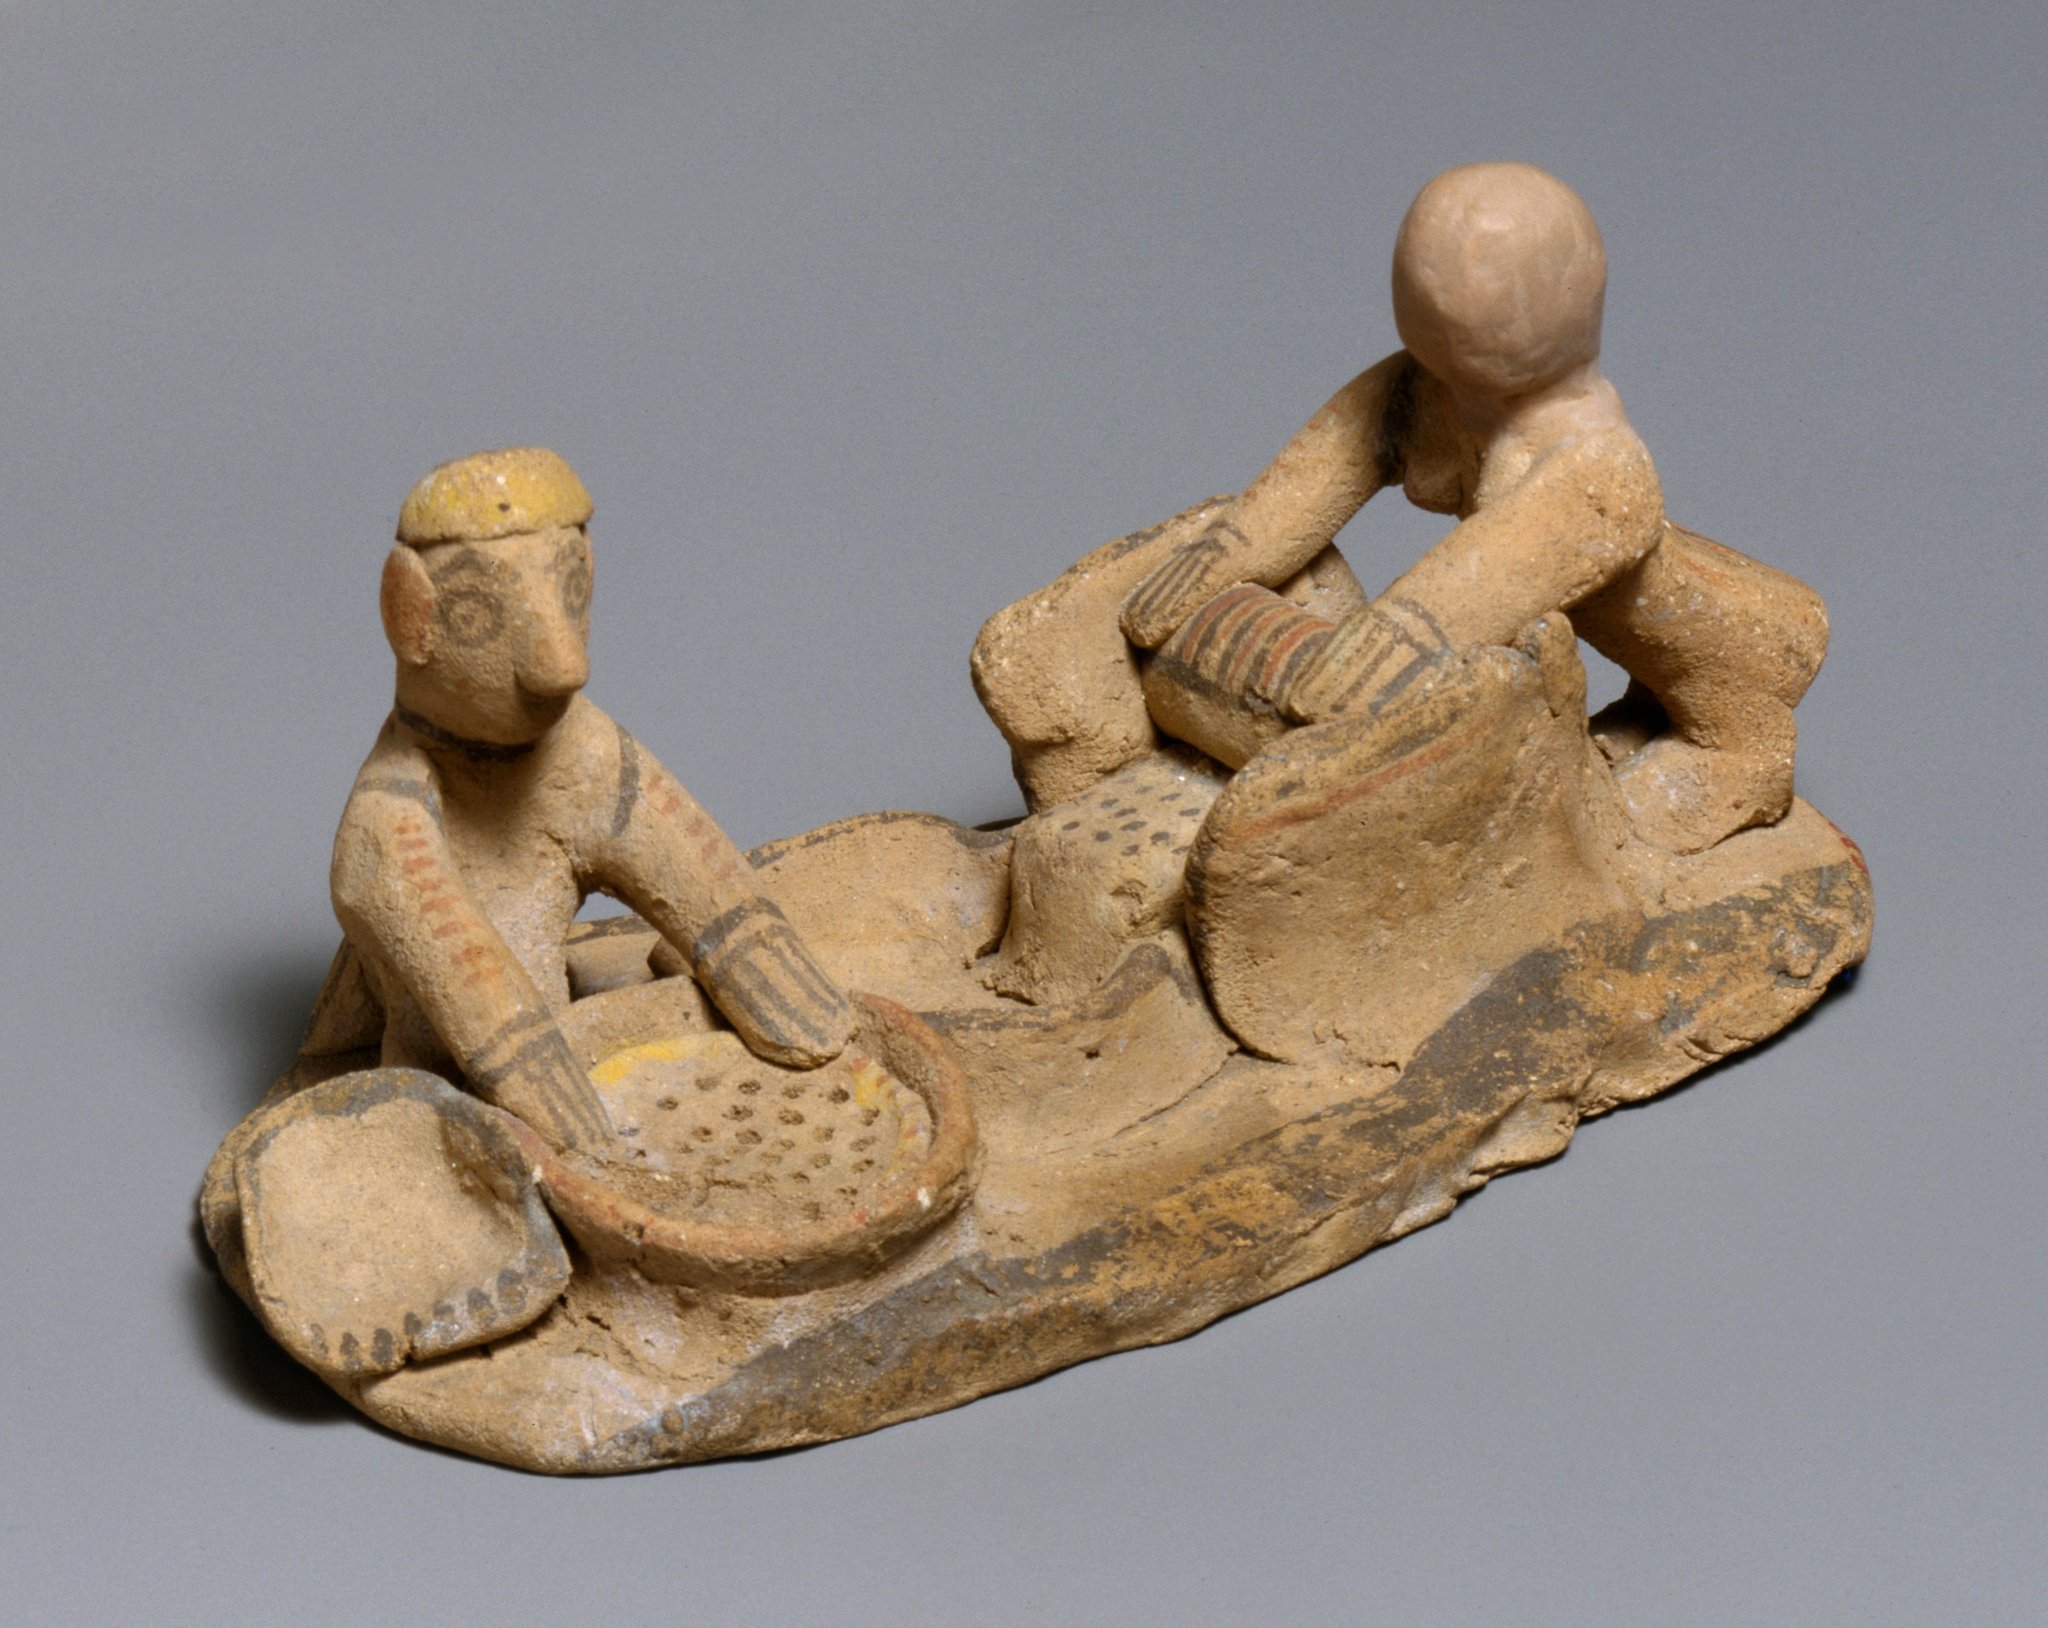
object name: statuette group of woman grinding grain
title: Terracotta group: making flour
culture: cypriot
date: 600-480 BCE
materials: terracotta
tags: food,women,working